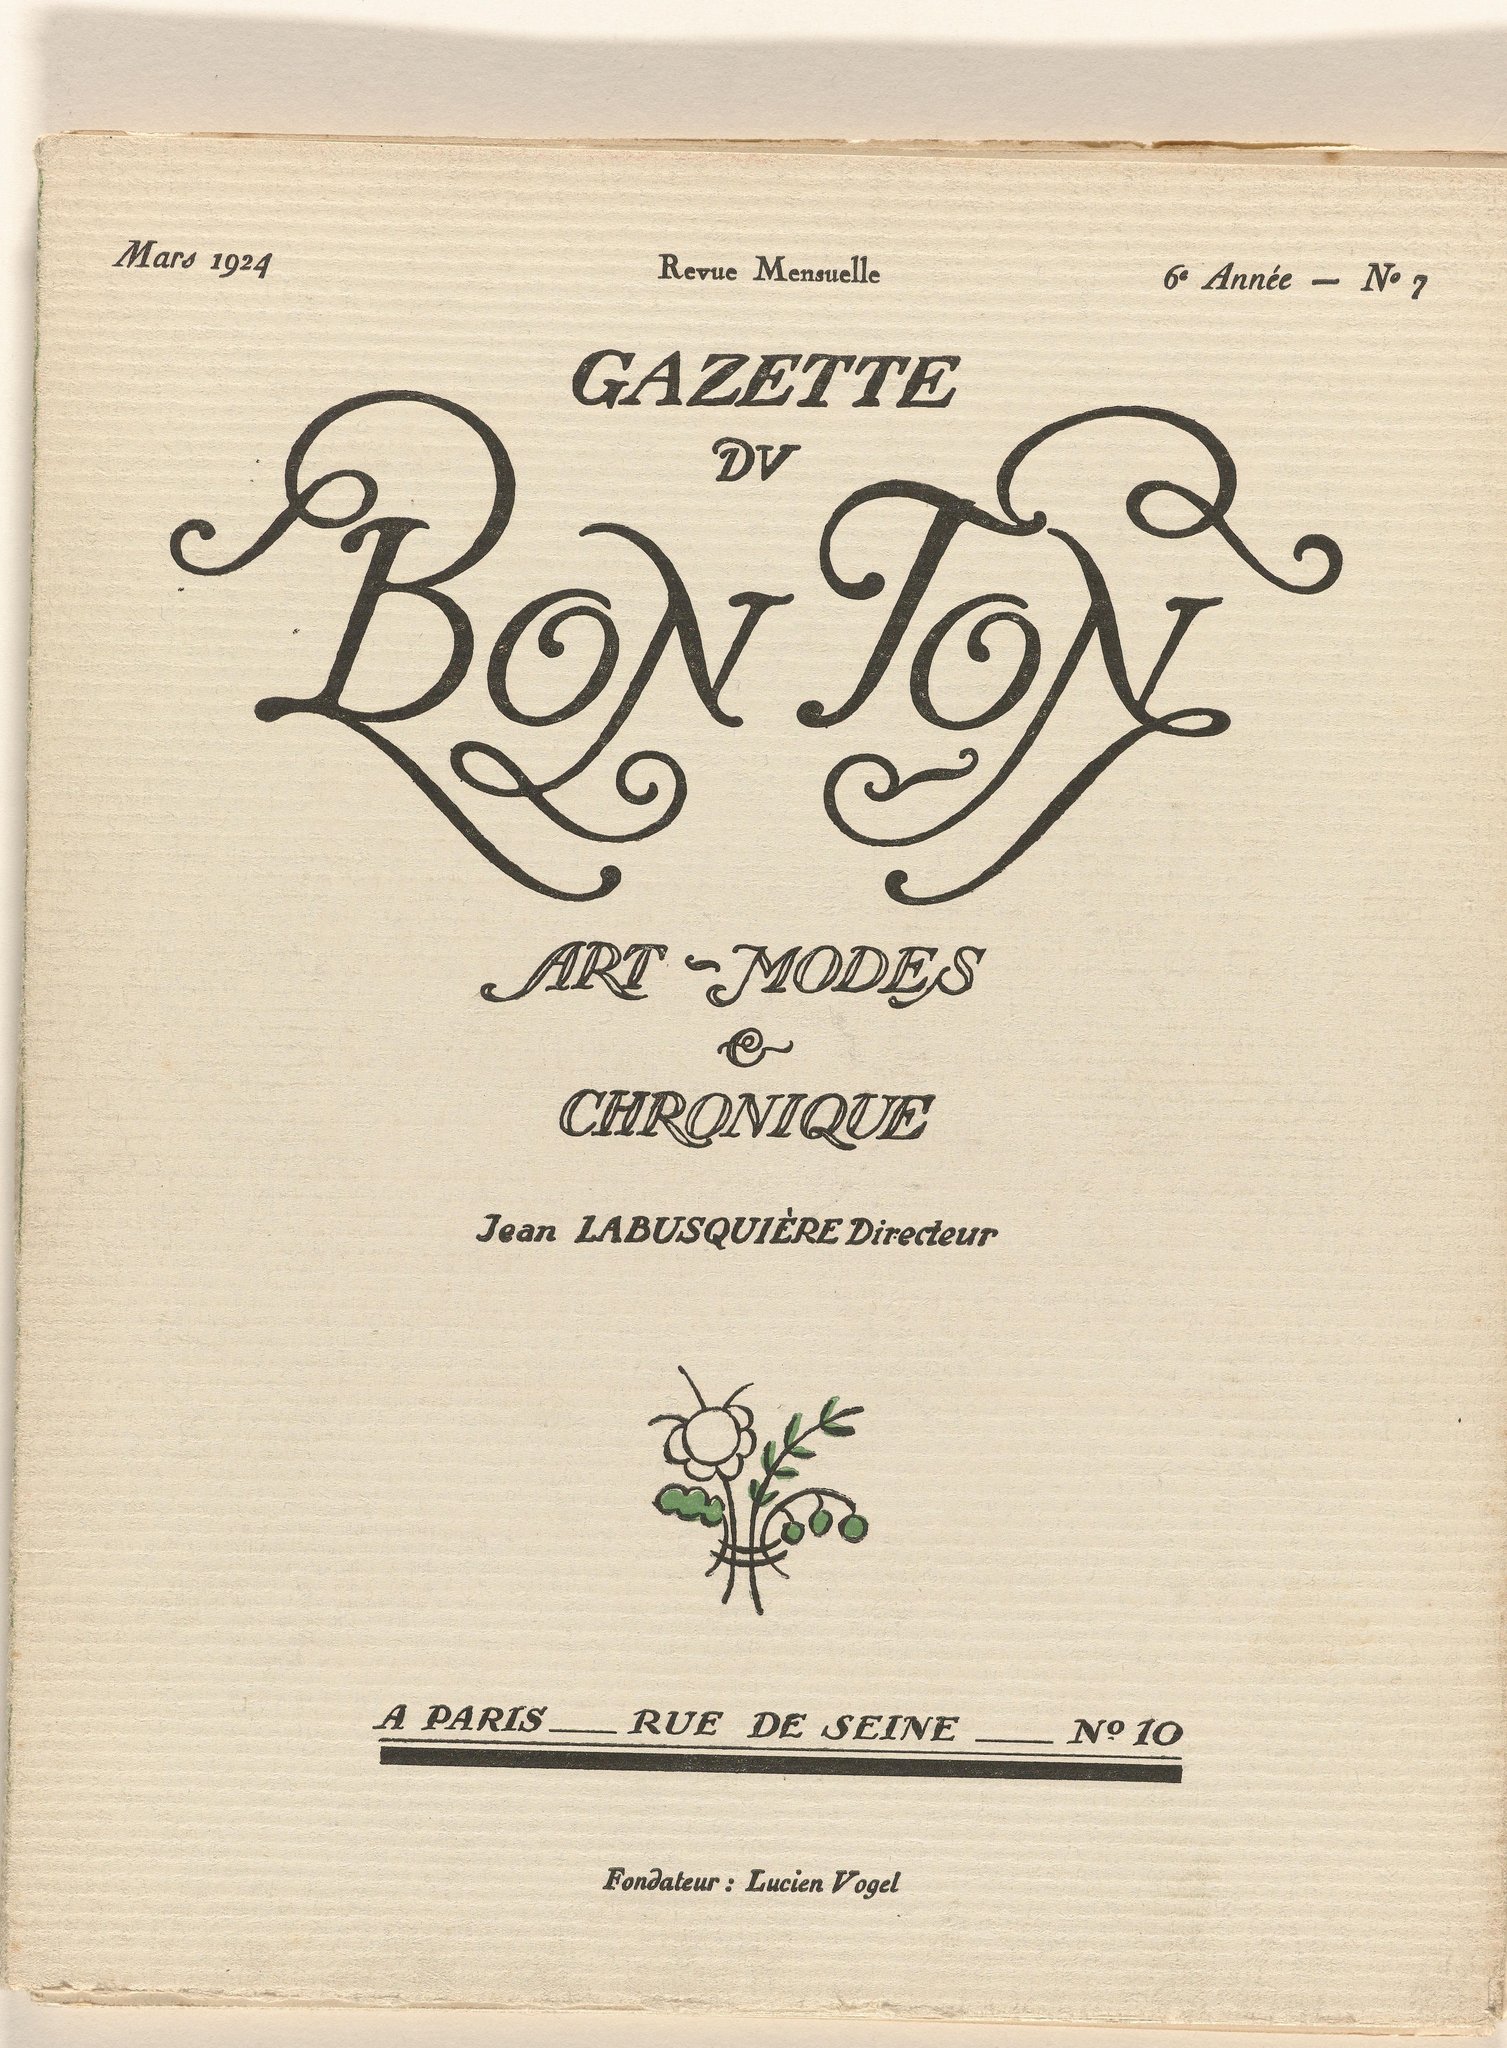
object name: magazine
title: Gazette du Bon Ton. Art - Modes & Frivolités, No. 7 - 1924, 6e Année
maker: lucien vogel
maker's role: publisher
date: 1924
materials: paper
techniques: letterpress printing, pochoir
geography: paris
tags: fashion plates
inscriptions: date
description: Aflevering no. 7, maart 1924, van Gazette du Bon Ton, bestaand uit een omslag, tien katernen met tekst en illustraties en acht losse prenten. Aan dit deel werkten de volgende modeontwerpers mee: Jenny, Lanvin, Paul Poiret, Madeleine Vionnet, Worth, Max A. Leroy, Perugia, Marthe Collot, Rodier, Bianchini en Ducharne.